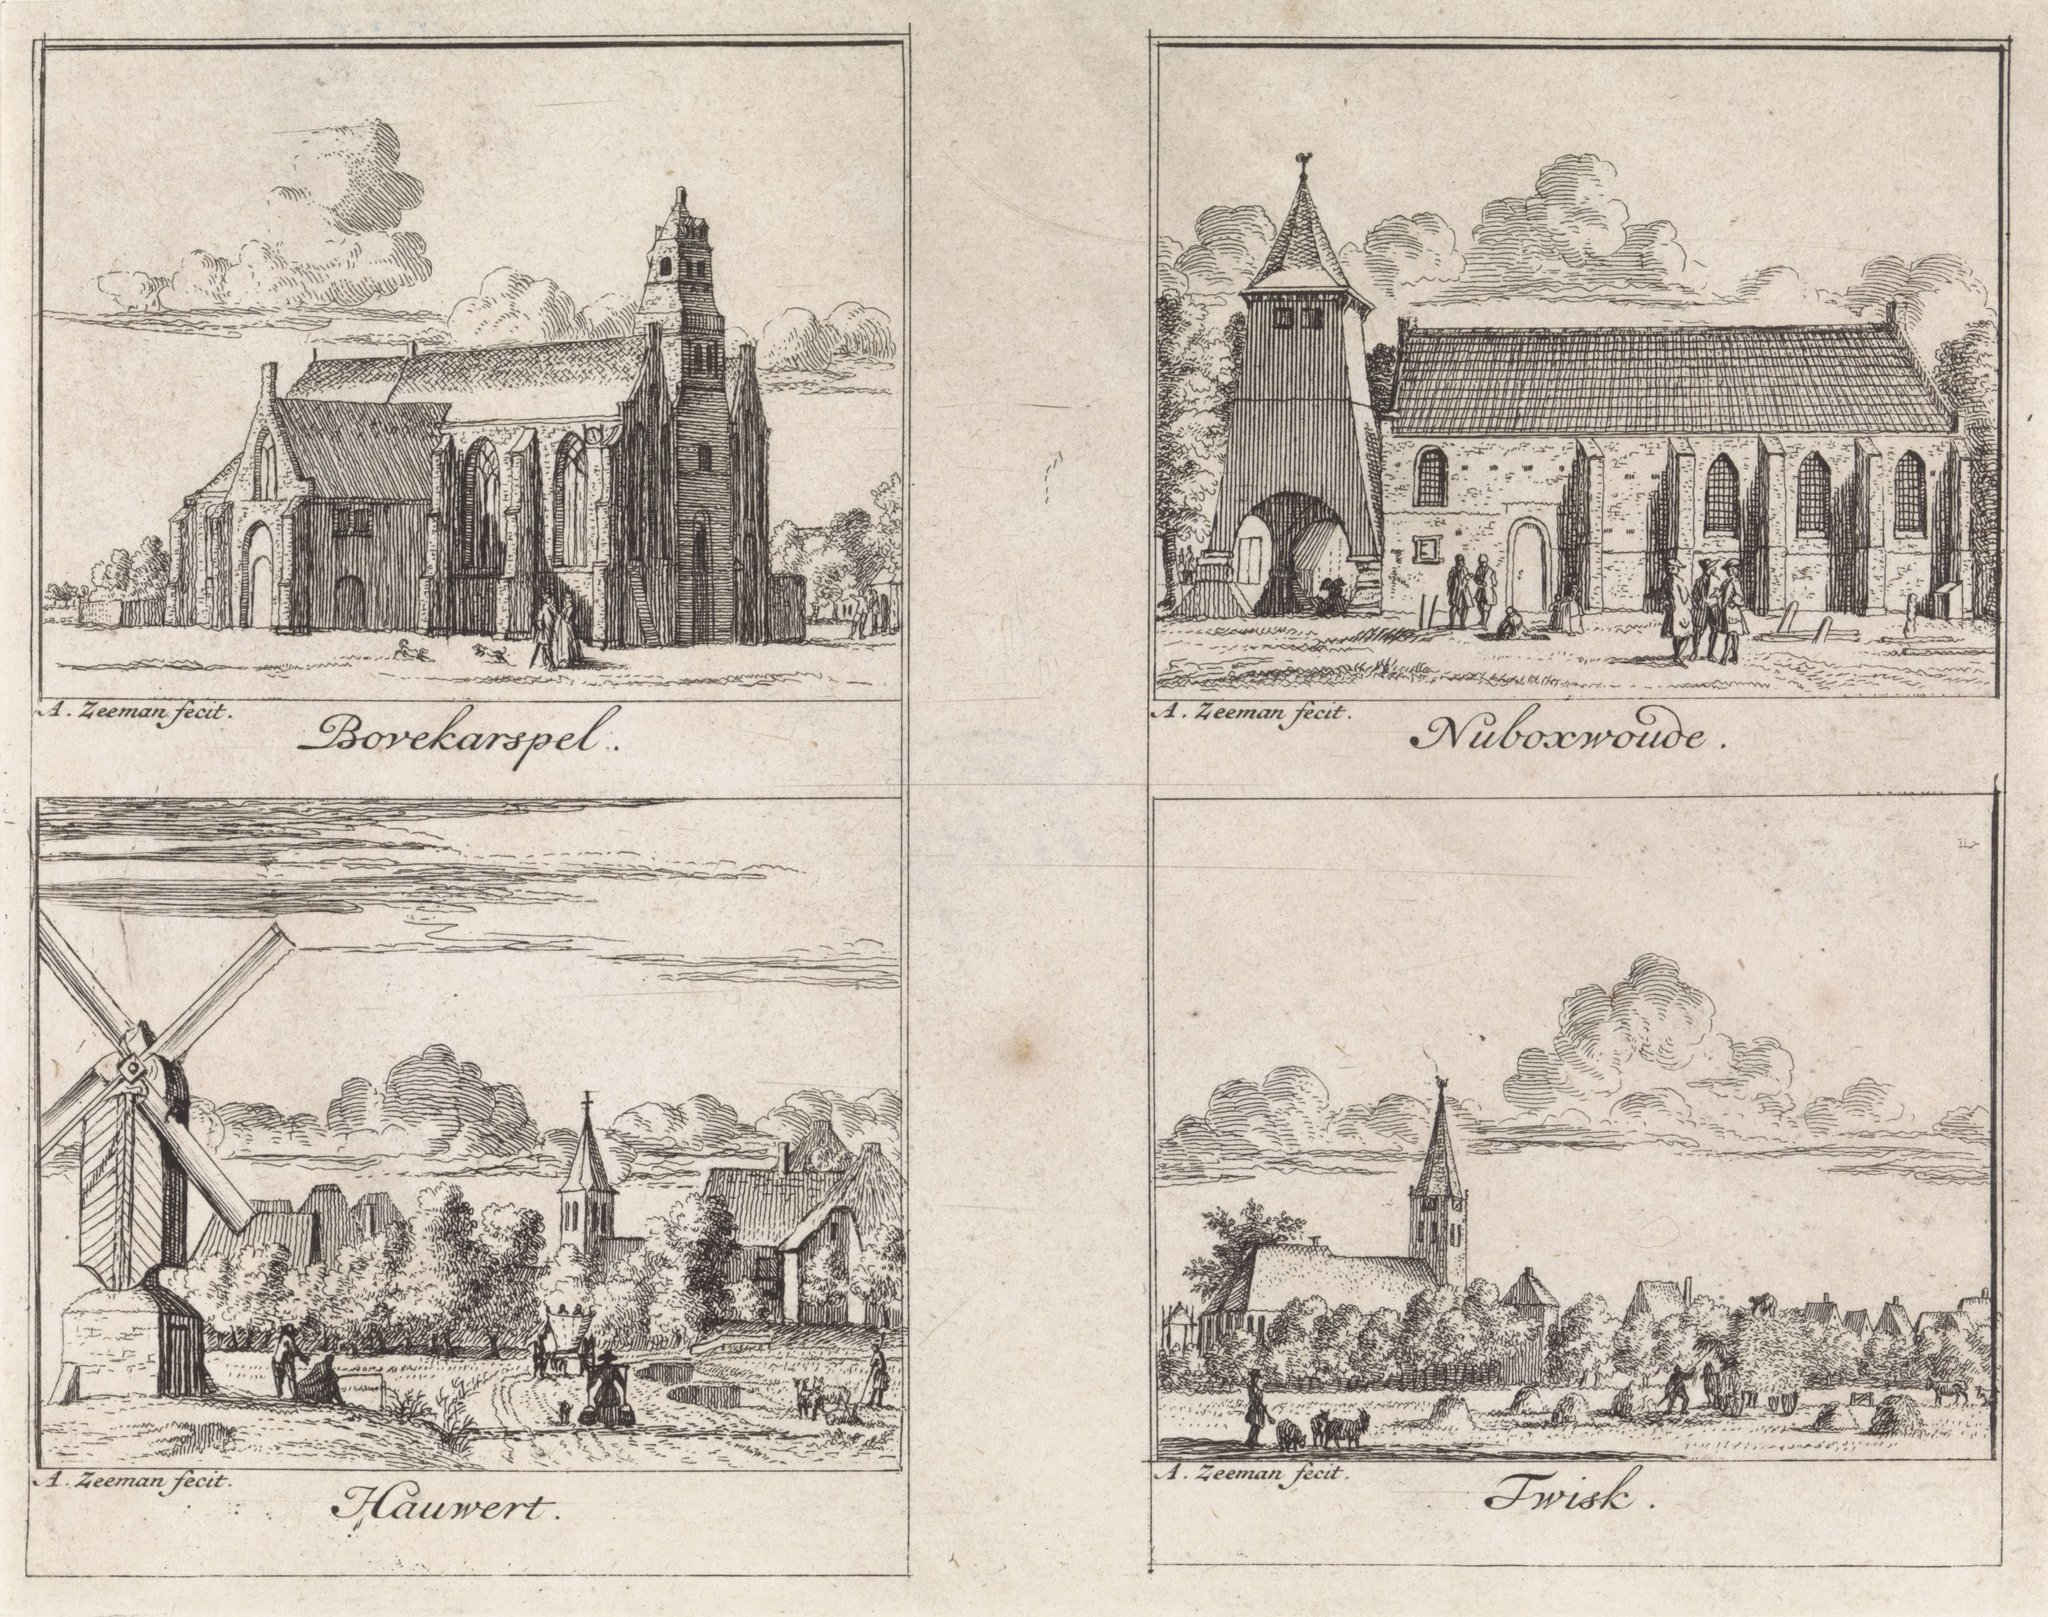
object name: print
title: Bovekarspel / Hauwert / Nuboxwoude / Twisk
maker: abraham zeeman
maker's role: print maker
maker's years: 1695-1754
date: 1732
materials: paper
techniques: etching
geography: amsterdam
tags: prospect of village, silhouette of village, church (exterior)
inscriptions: collector's mark: Lugt 2228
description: Vier voorstellingen op een blad. Linksboven: Gezicht op de kerk van Bovenkarspel. Linksonder: Gezicht op het dorp Hauwert. Rechtsboven: Gezicht op de kerk van Nibbixwoud. Rechtsonder: Gezicht op het dorp Twisk.